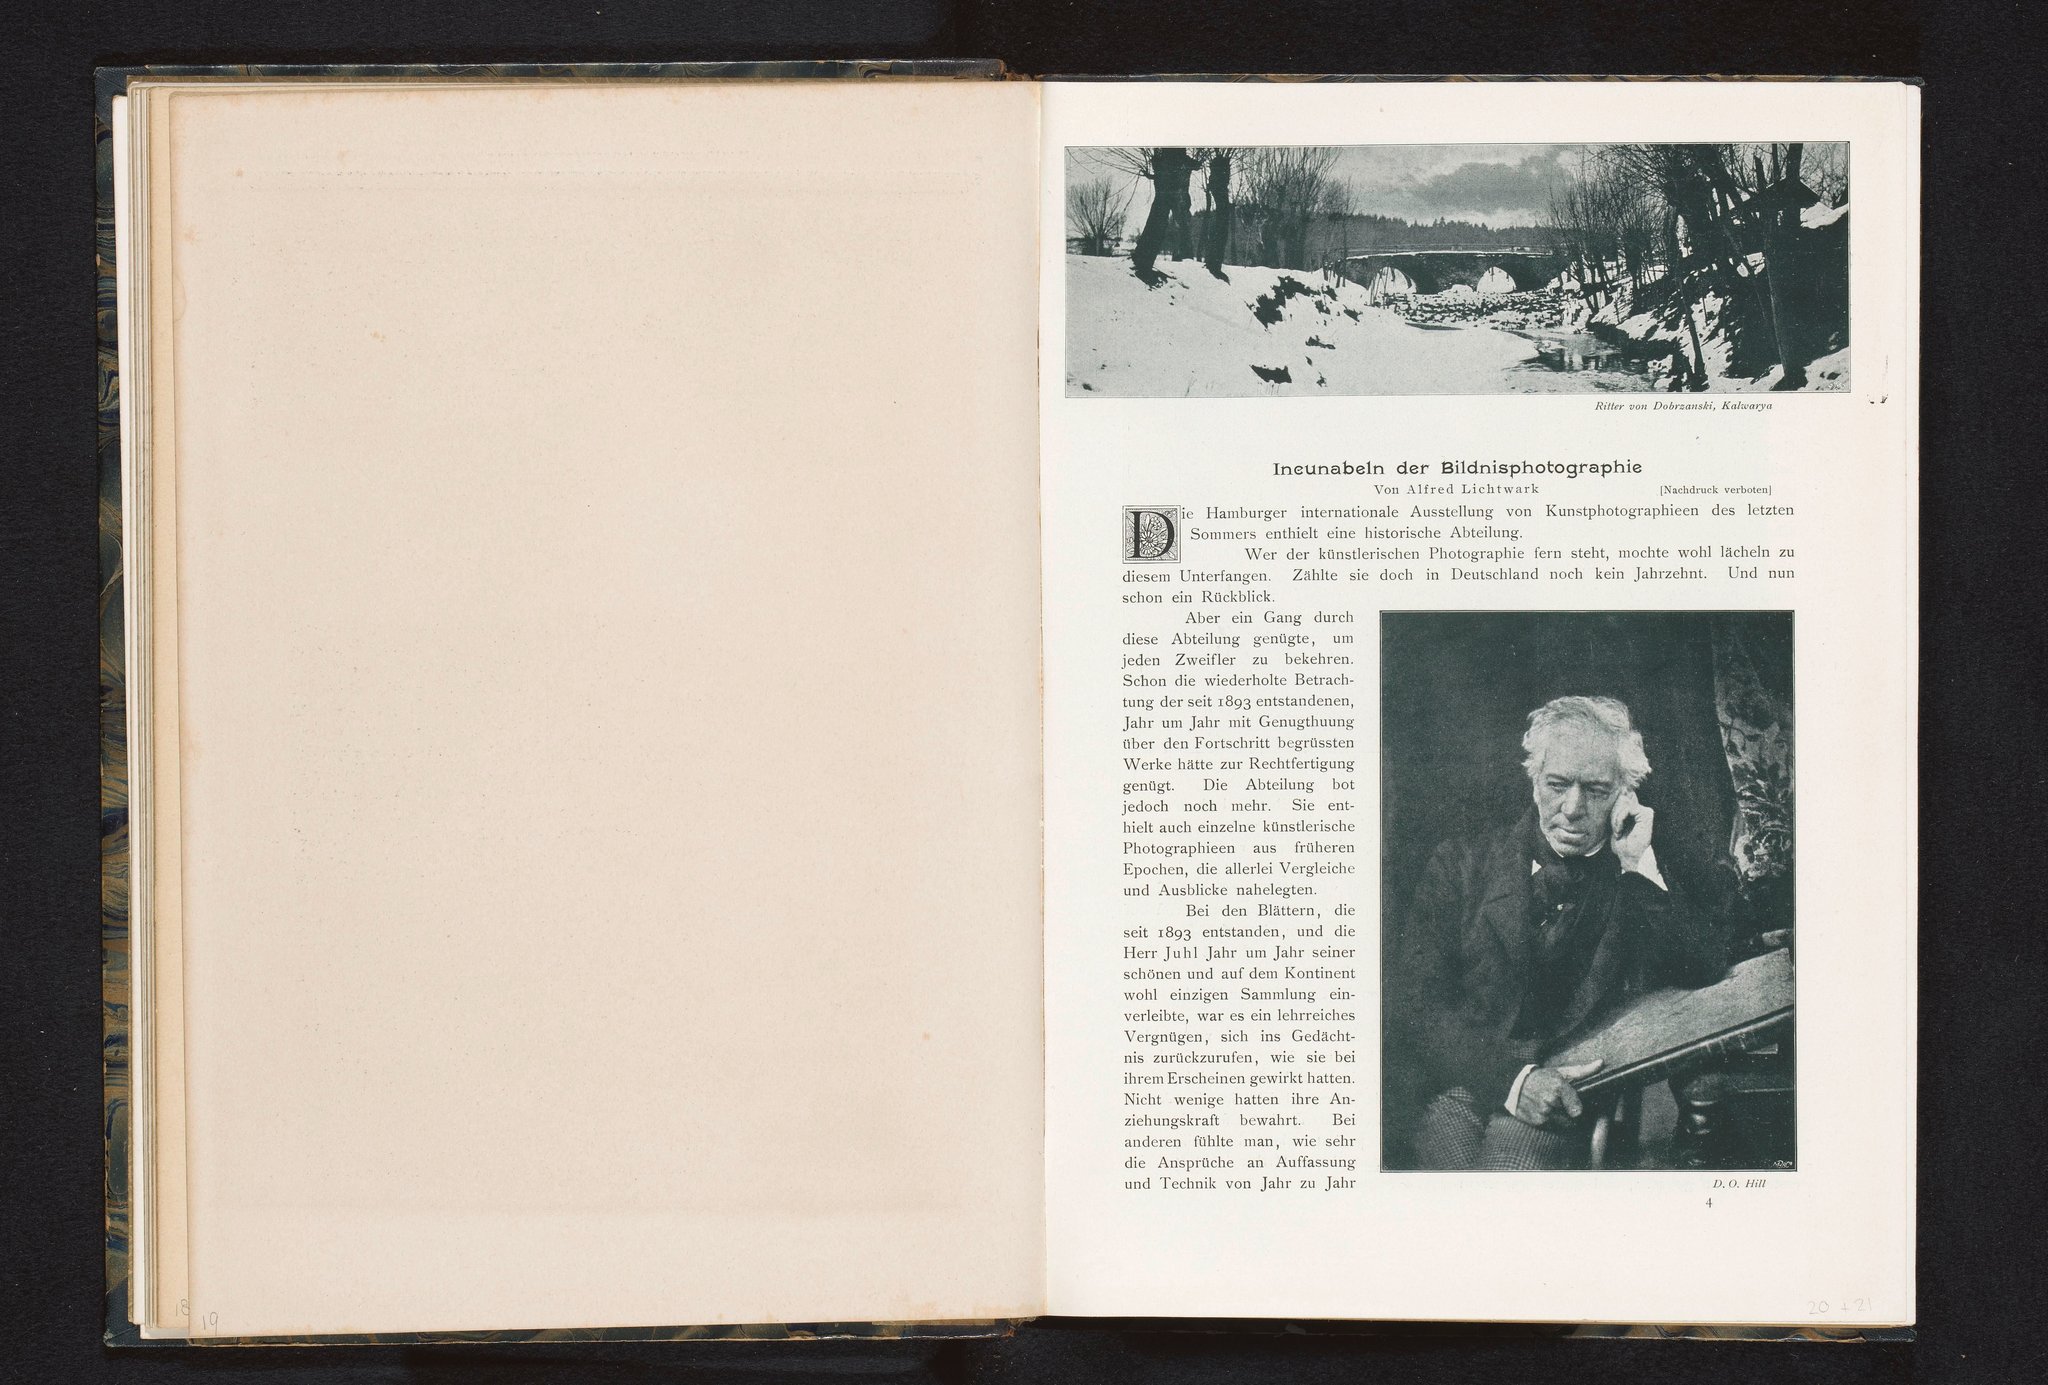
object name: photomechanical print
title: Vermoedelijk portret van Octavius Hill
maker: david octavius hill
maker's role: fotograaf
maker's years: 1802-1870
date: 1895-1900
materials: paper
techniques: autotype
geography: berlin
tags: adult man, anonymous historical person portrayed